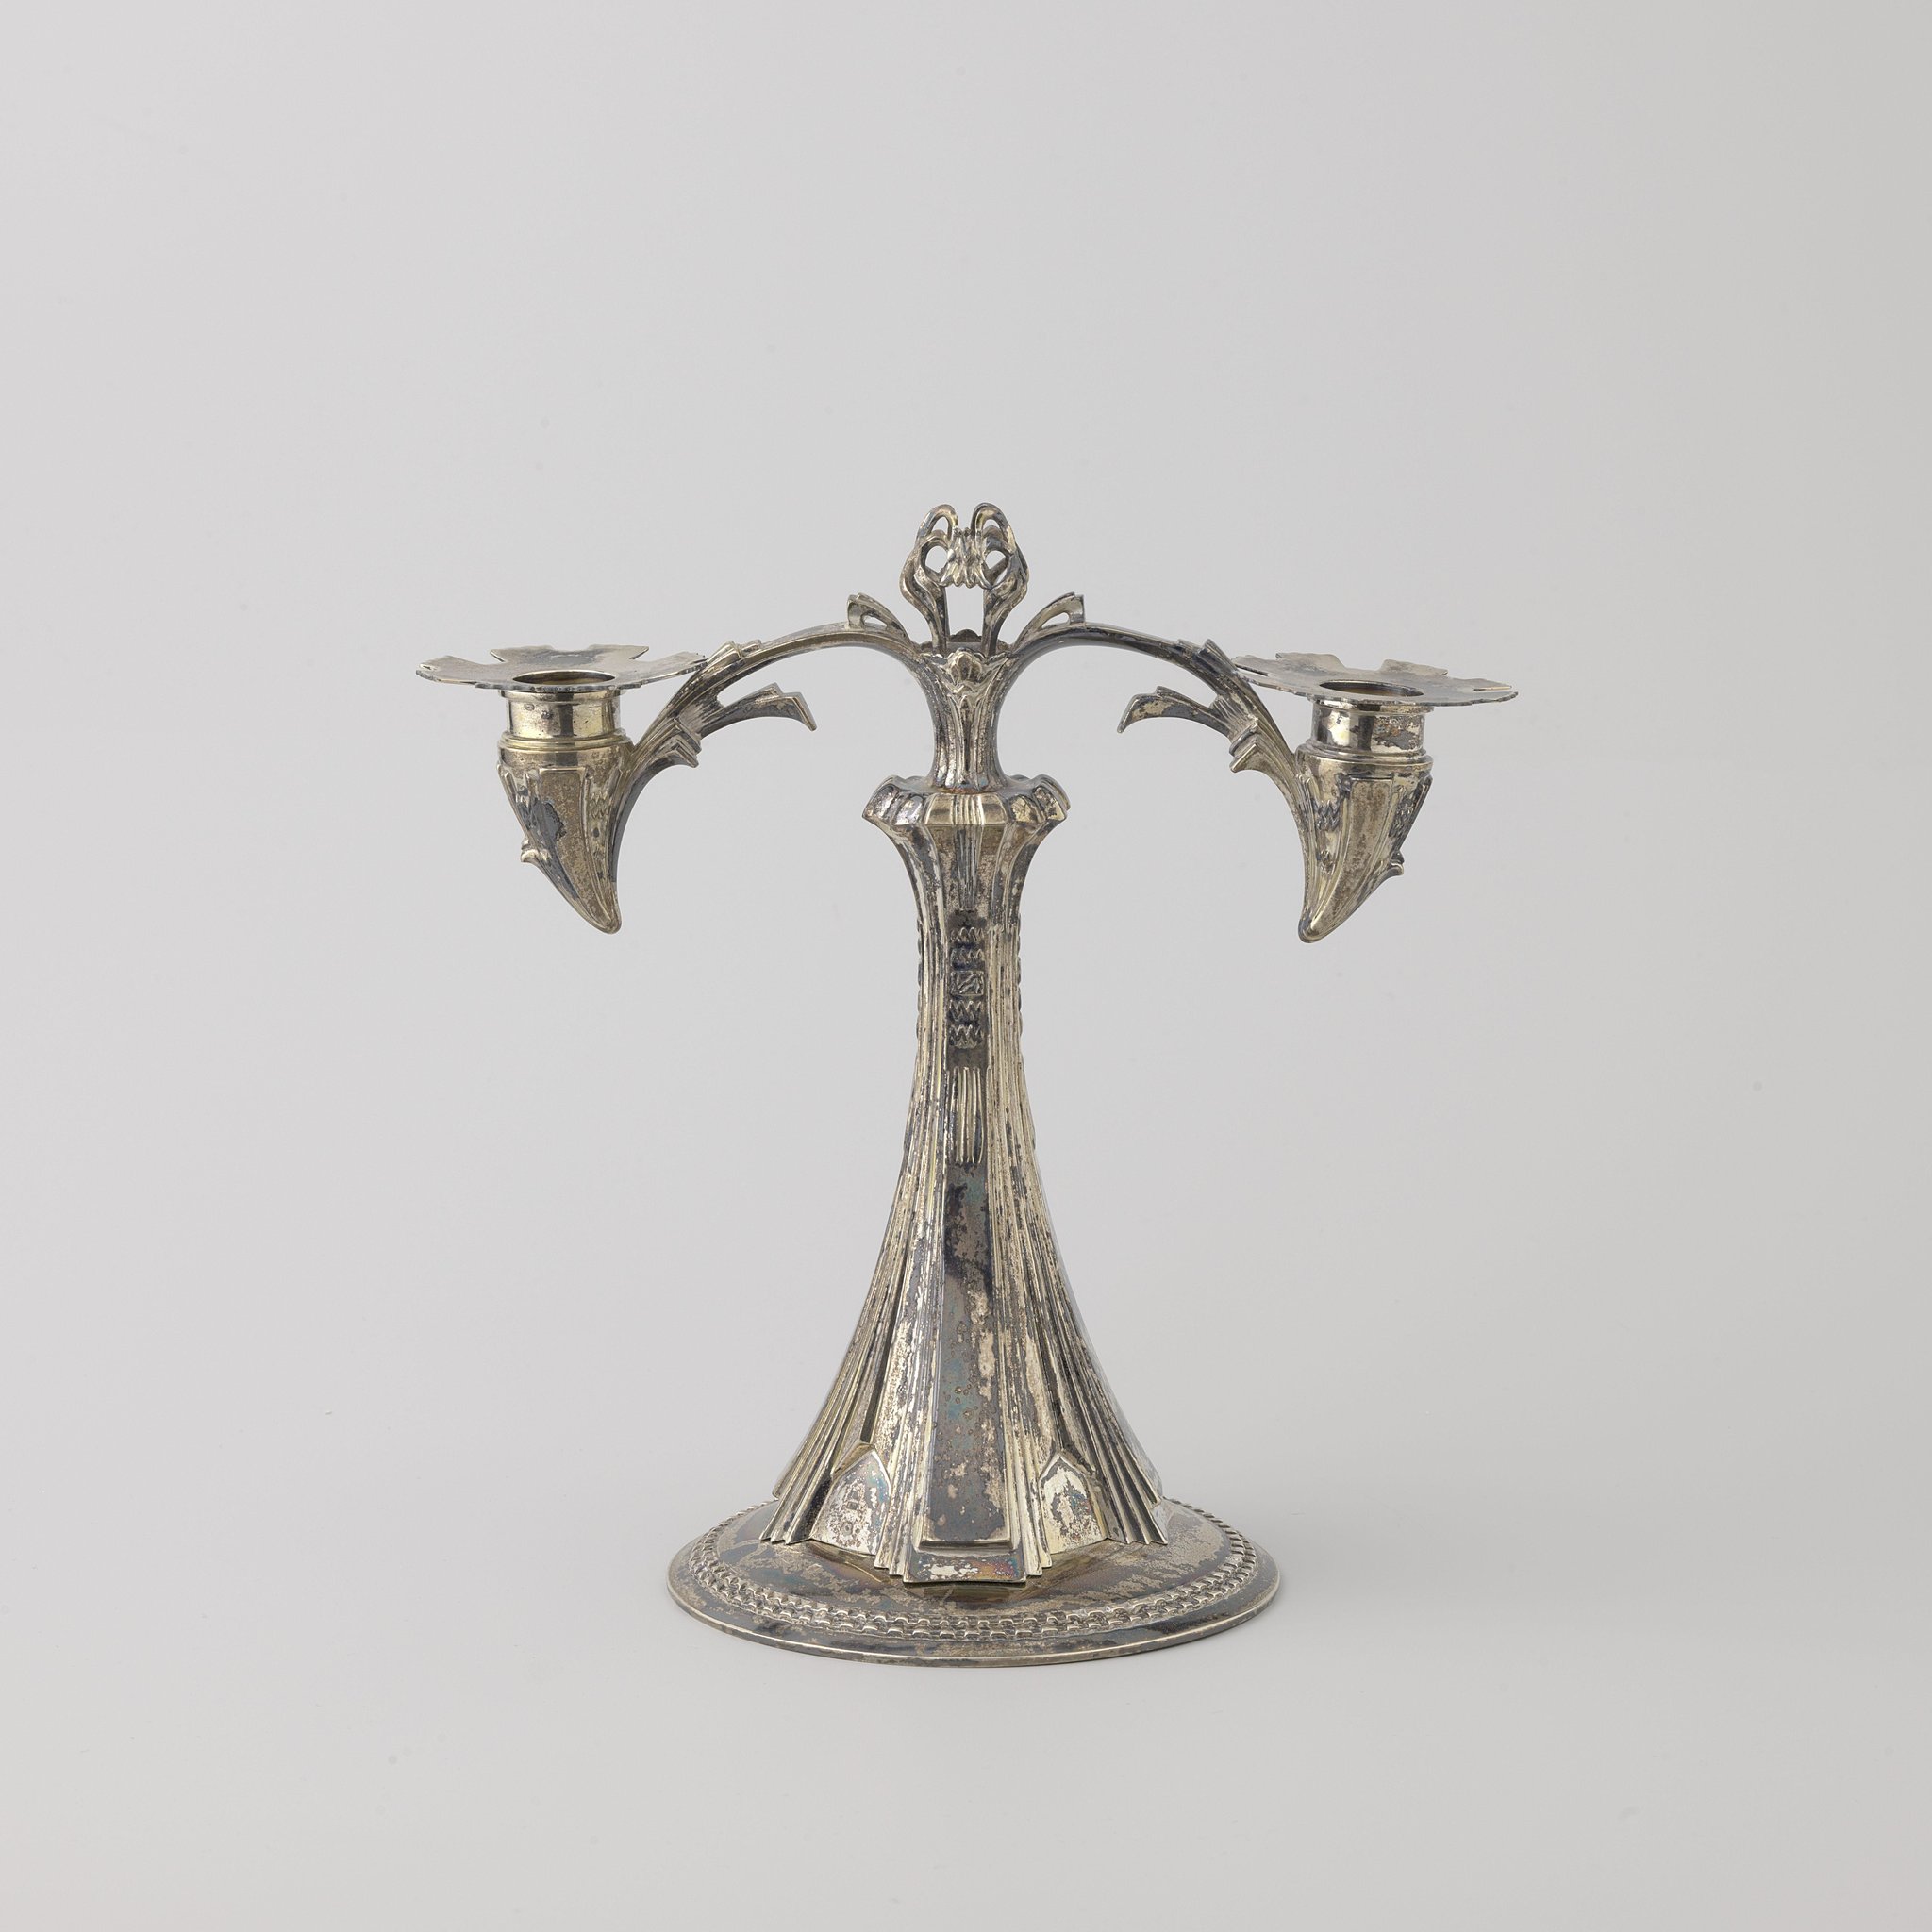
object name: candelabrum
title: Kandelaber op ronde voet. Uit de stam ontspringen twee gebogen armen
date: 1905-1920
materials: silver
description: Two candelabra. Silver. Vienna, c. 1905 - 1920, by J.C. Klinkosch.